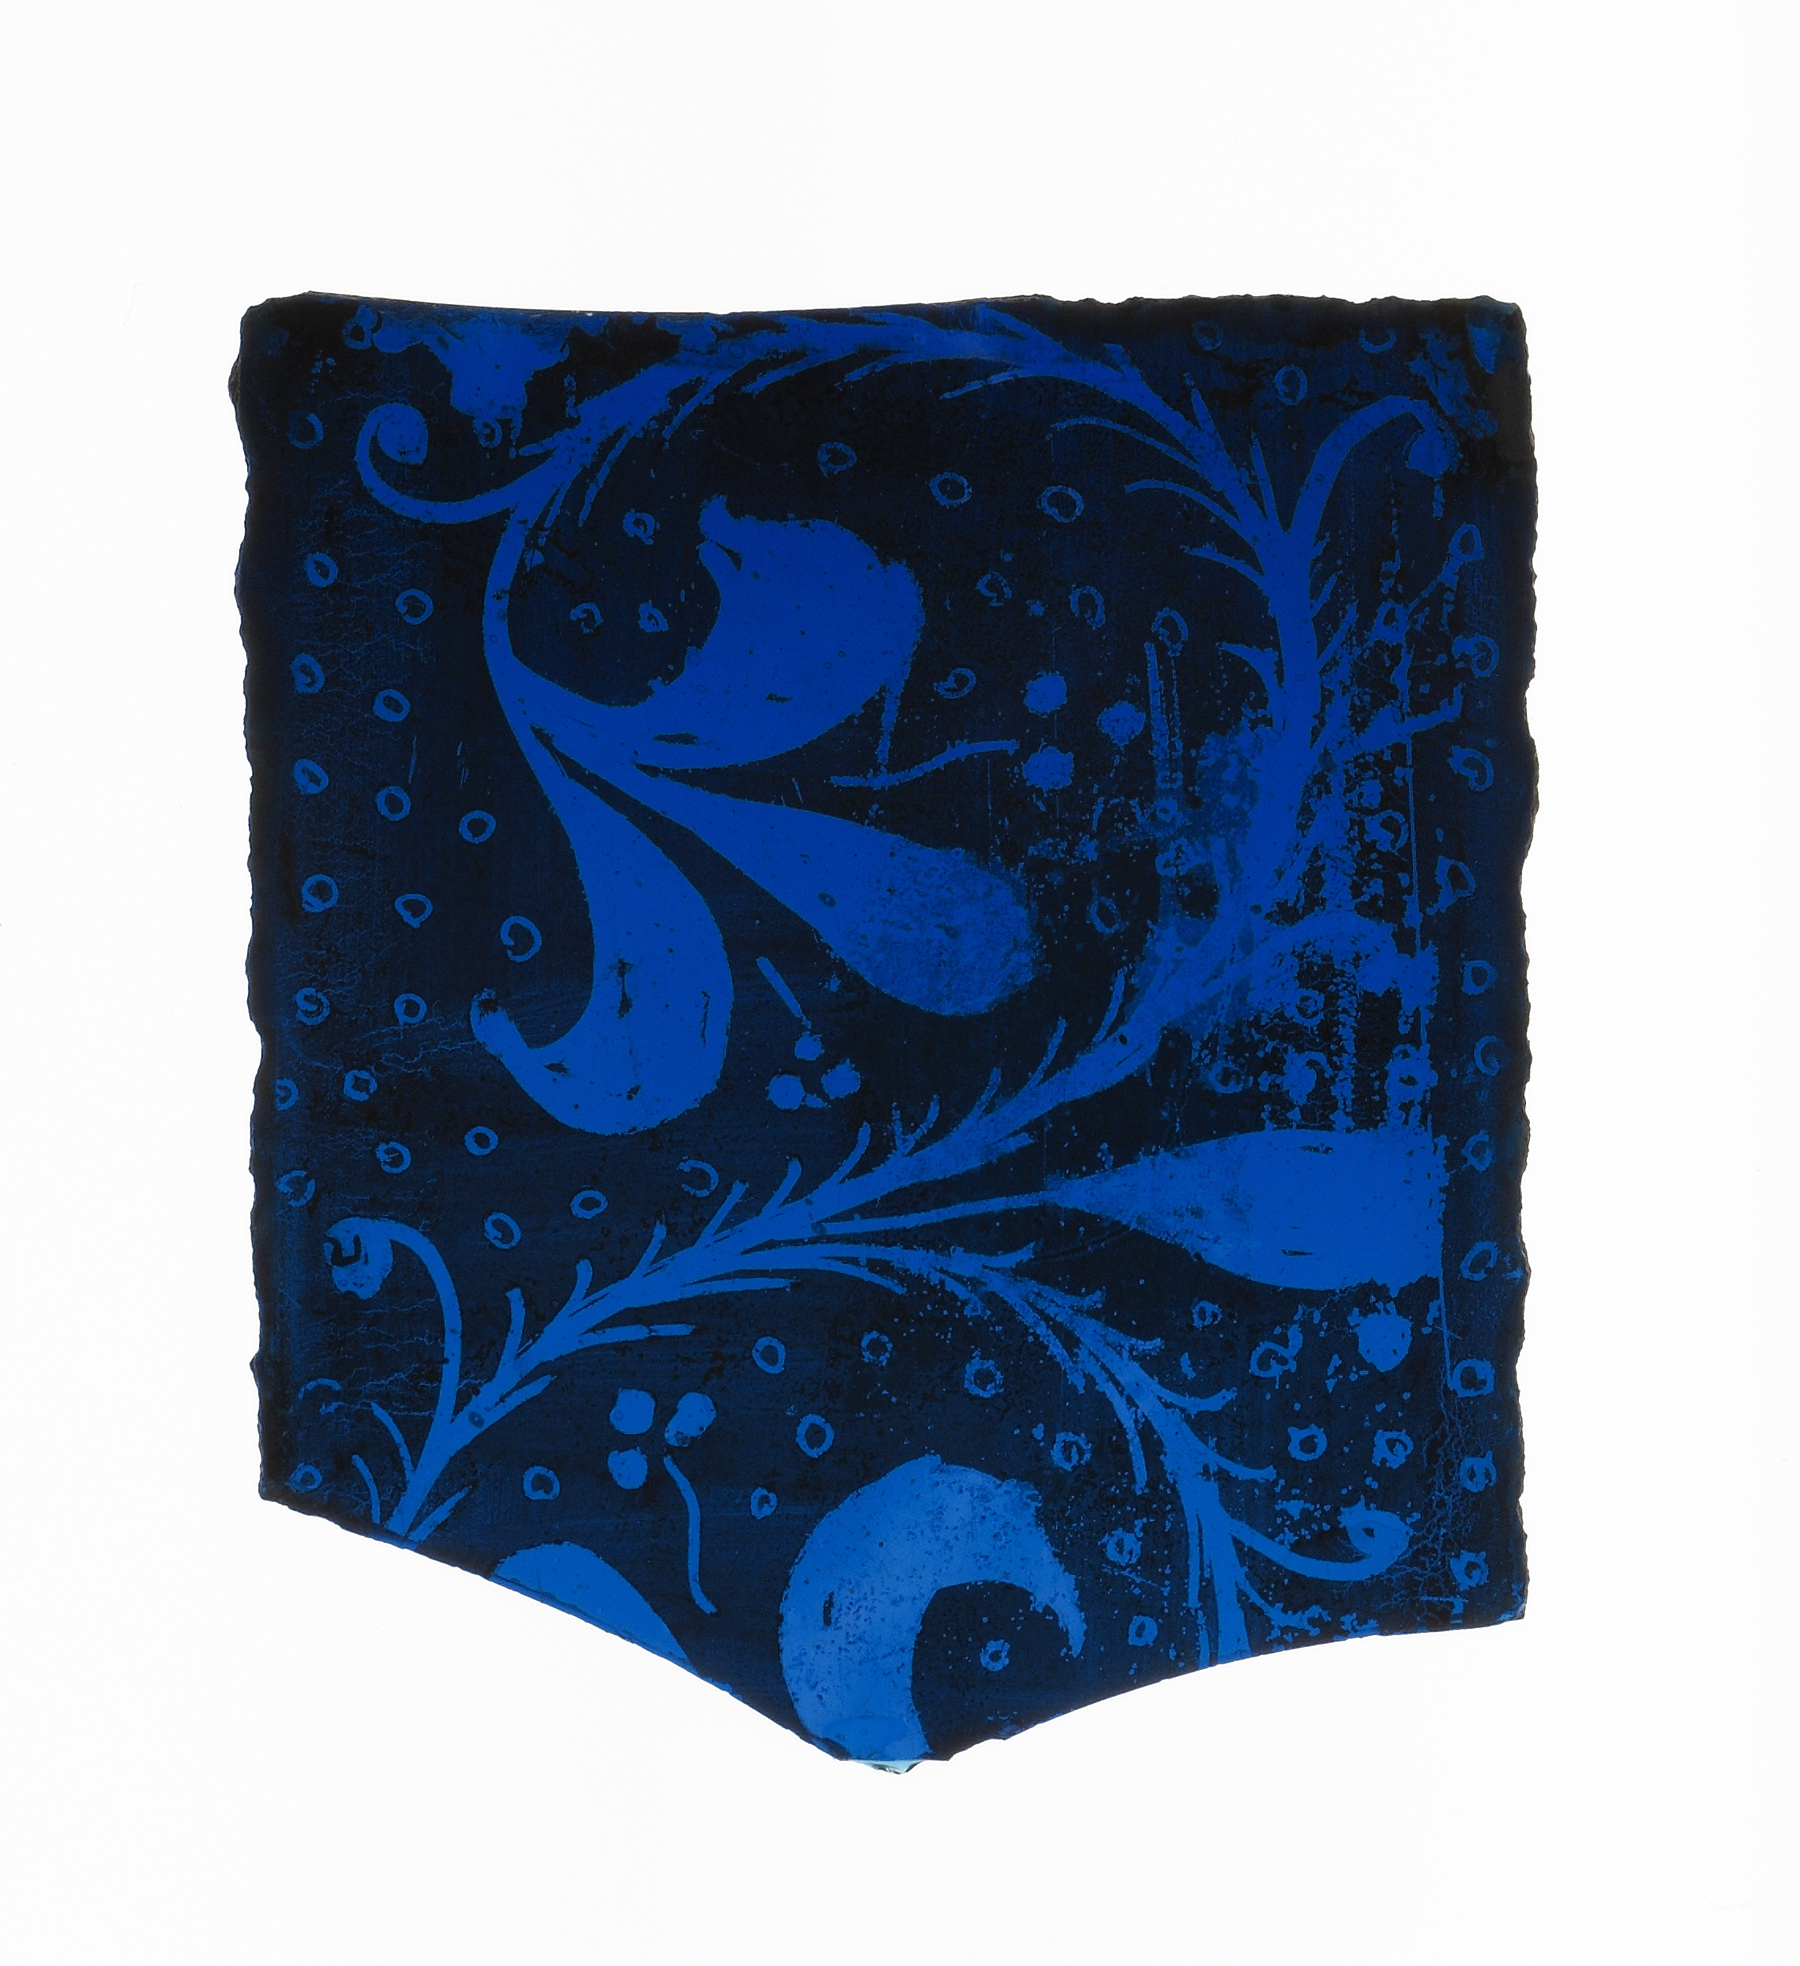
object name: fragment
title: Glass Fragment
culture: french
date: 1401-1500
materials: glass, metal, paint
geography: france